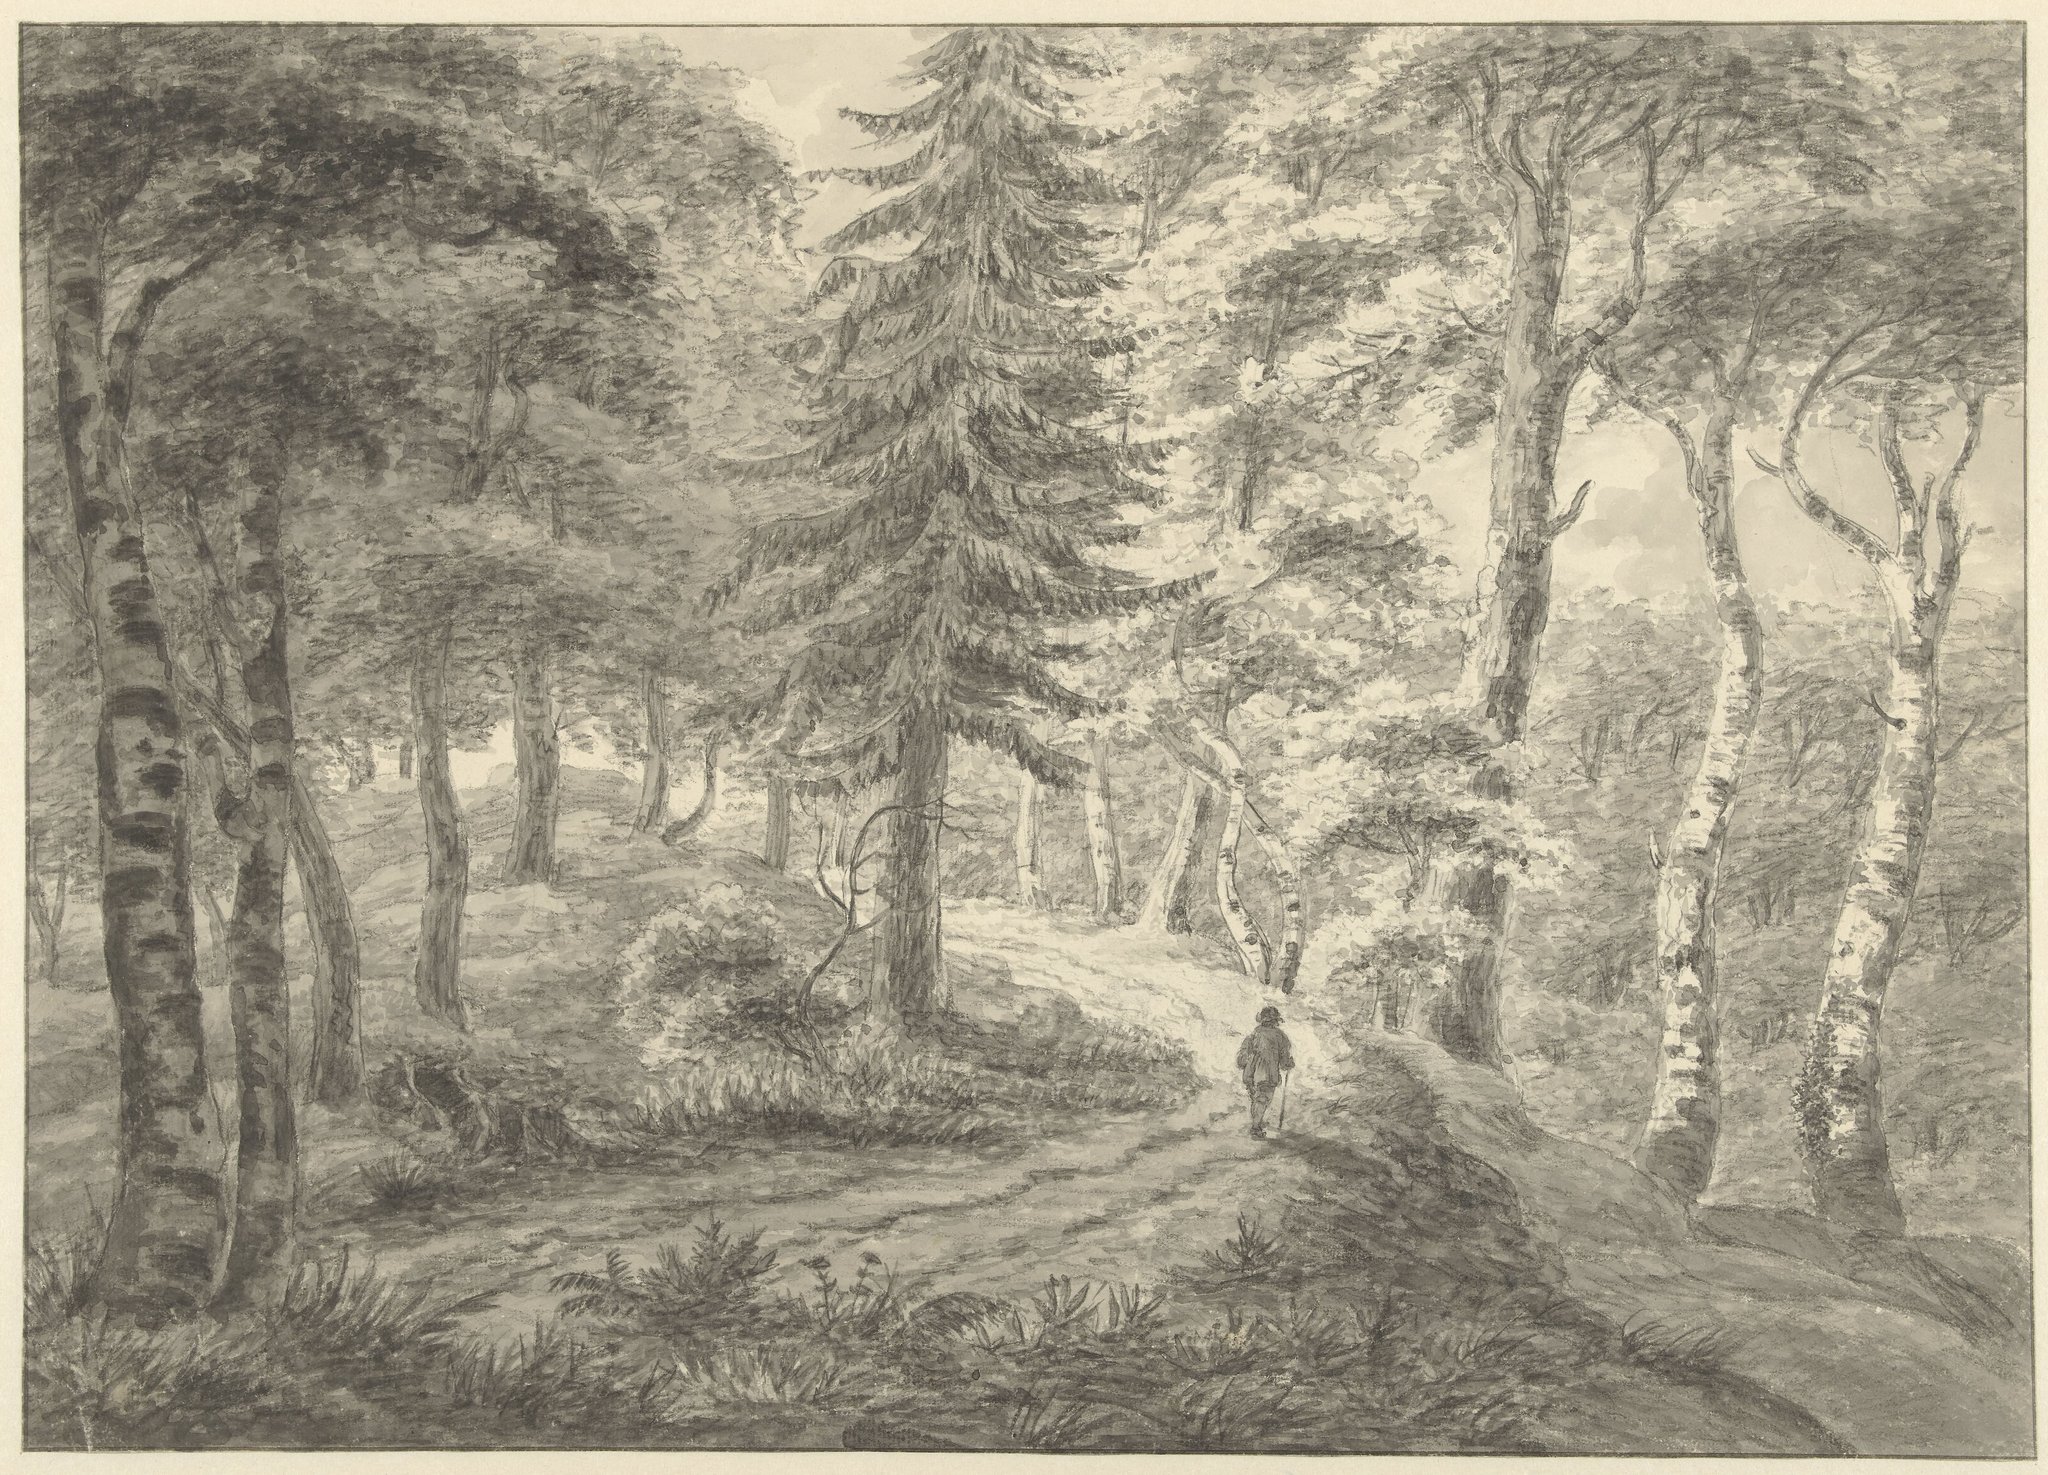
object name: drawing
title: Bosgezicht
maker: engelbert michaël engelberts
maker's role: draughtsman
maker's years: 1773-1843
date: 1783-1843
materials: chalk, paper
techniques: brush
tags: forest, wood